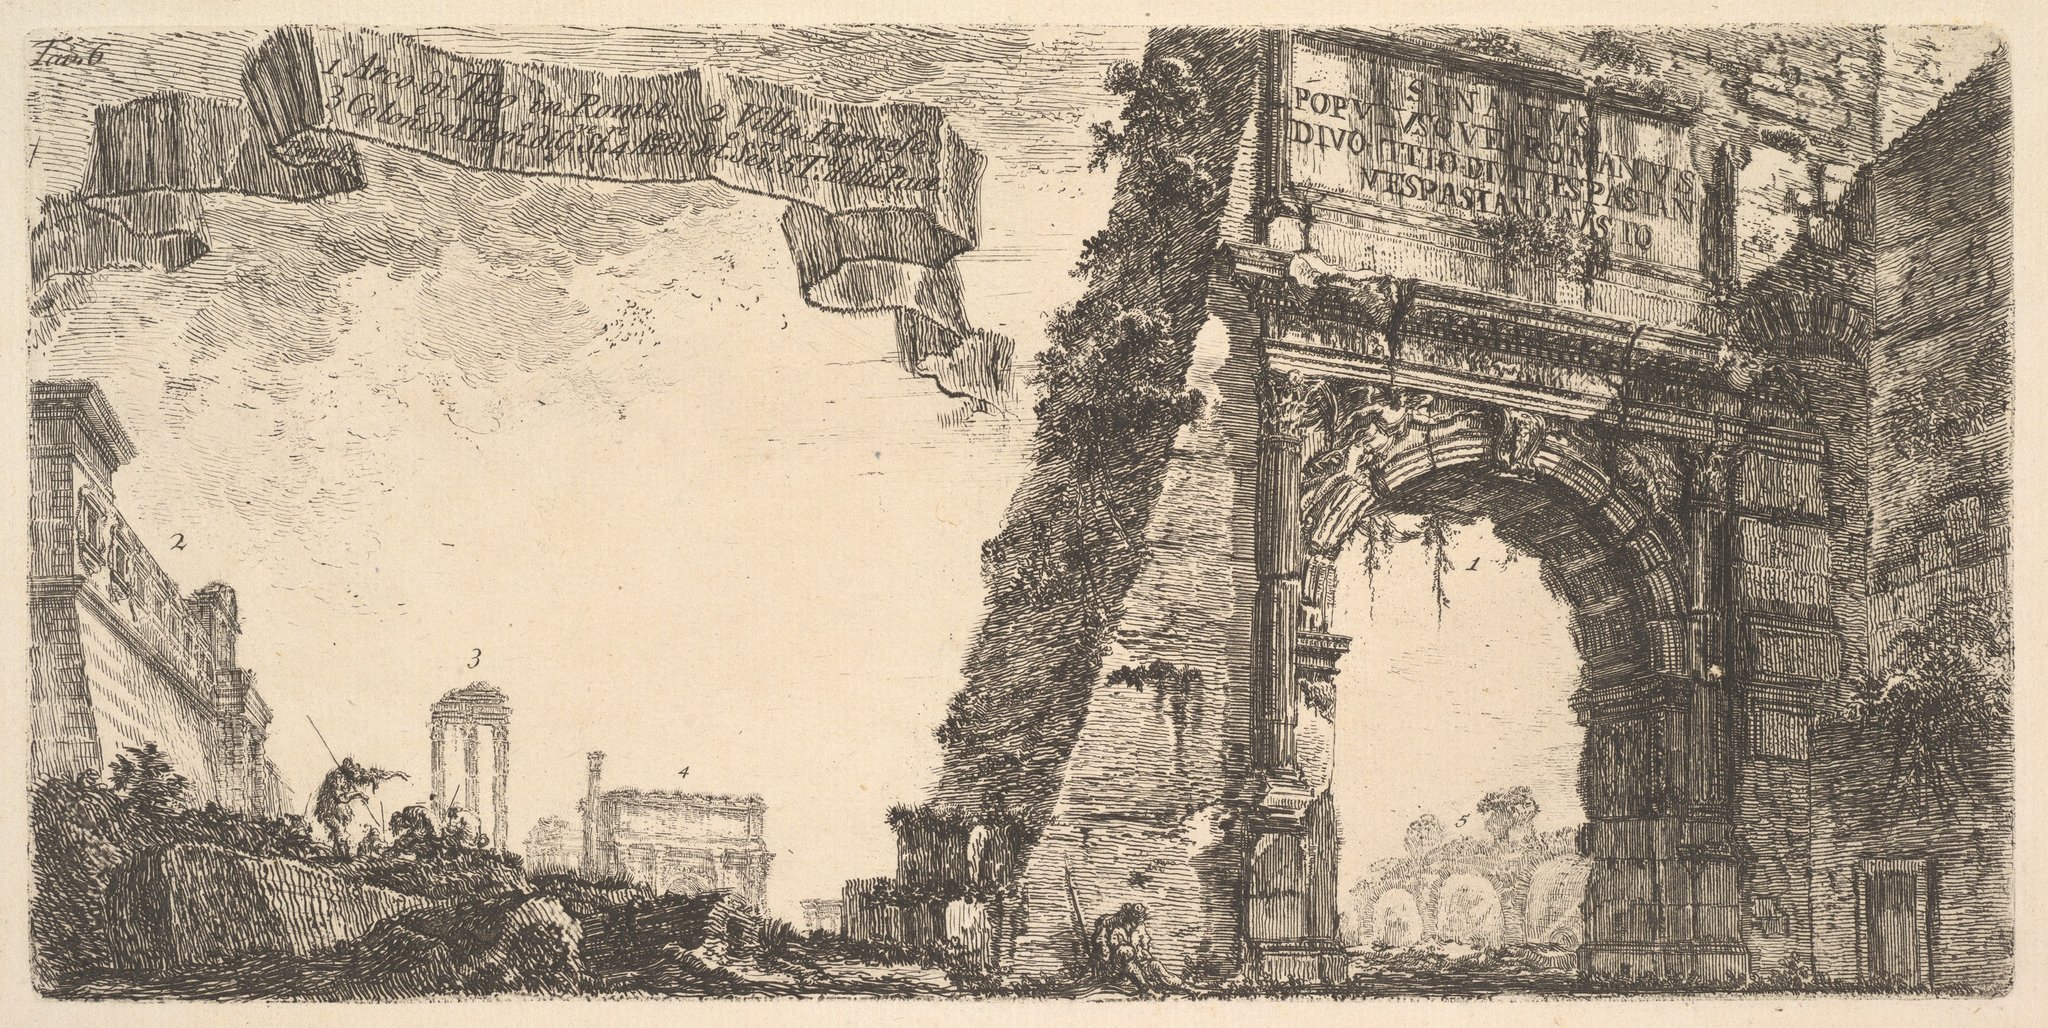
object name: print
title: Plate 6: 1. Arch of Titus. 2. Villa Farnese. 3. Columns of the Temple of Jupiter Stator (the Supporter). 4. Arch of Septimus Severus. 5. Temple of Peace. (1. Arco di Tito in Roma. 2. Villa Farnese. 2. Colon.e. del Tem.o di G.ve St.re. 4. Ar.co di Set.o...), from "Antichità Romane de' Tempi della Repubblica, e de' primi Imperatori"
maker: giovanni battista piranesi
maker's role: artist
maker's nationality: italian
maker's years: 1720-1778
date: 1748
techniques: etching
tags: arches,ruins